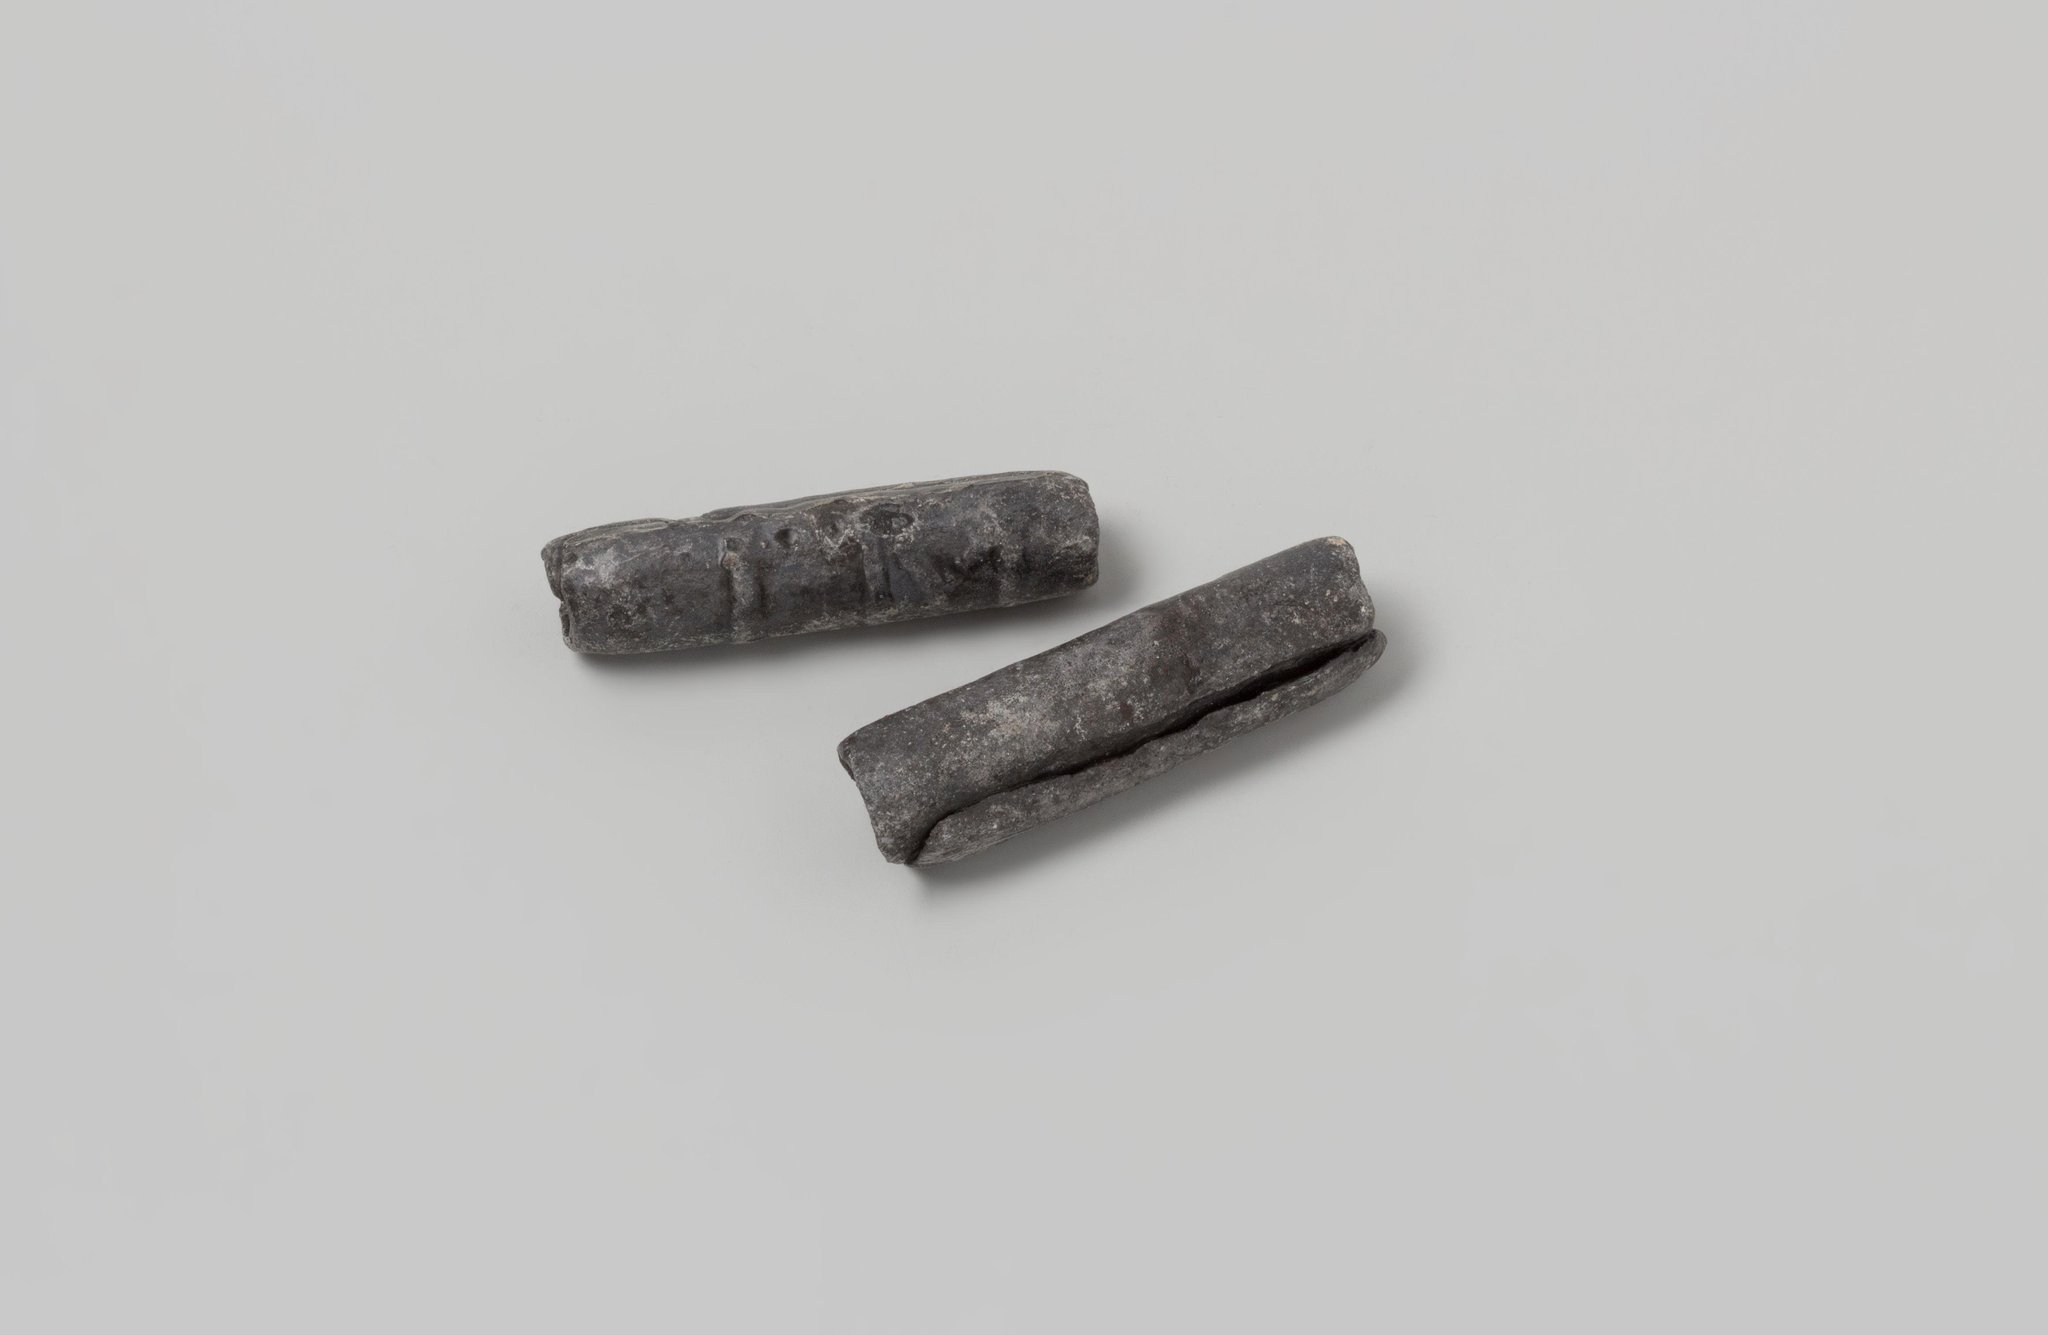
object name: lead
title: Loden rol uit het wrak van de Oost-Indiëvaarder 't Vliegend Hart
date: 1700-1735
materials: lead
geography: middelburg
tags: 't vliegend hart (schip), verenigde oostindische compagnie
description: Deze loden buisjes zijn vermoedelijk afkomstig van visnetten ofwel op TVliegend Hart zelf ofwel van vissers die hun netten aan het wrak verloren.